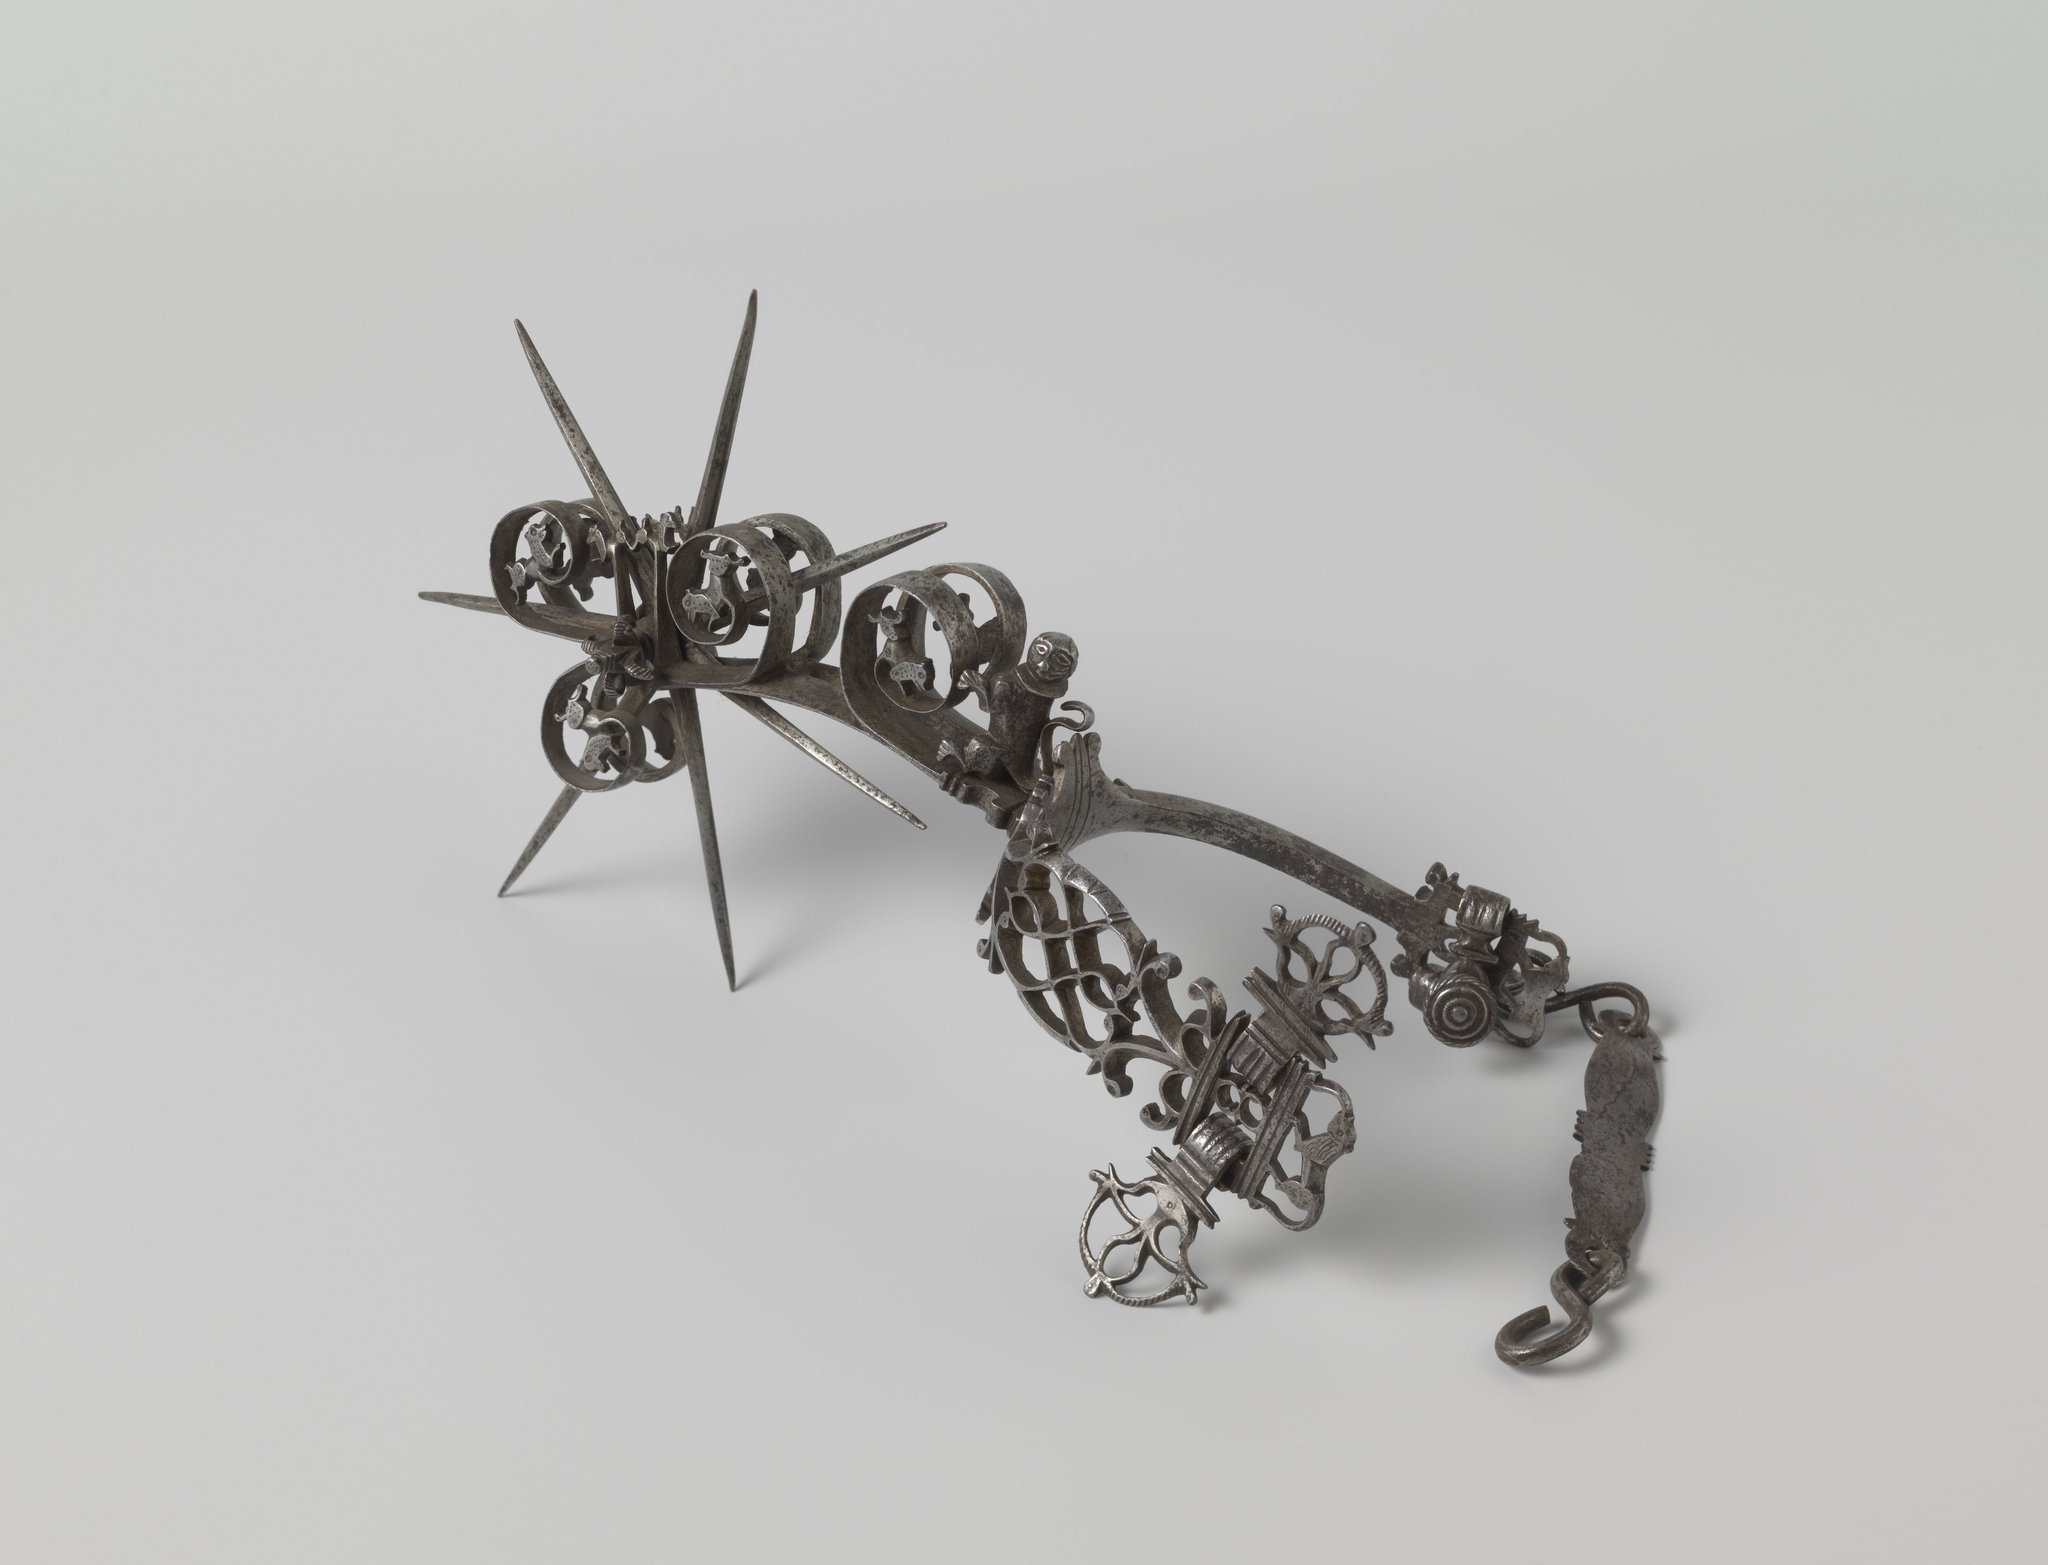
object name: spoor objectnaam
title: Ruiterspoor met zevenpuntige ster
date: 1625-1675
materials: iron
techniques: forging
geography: france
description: Een gesmeed ijzeren ruiterspoor, gildeproef; de prikkel in de vorm van een 7 puntige ster, de hiel versierd met in de dag gewerkt ornament, de spoor met voluten, waarin leeuwtjes.